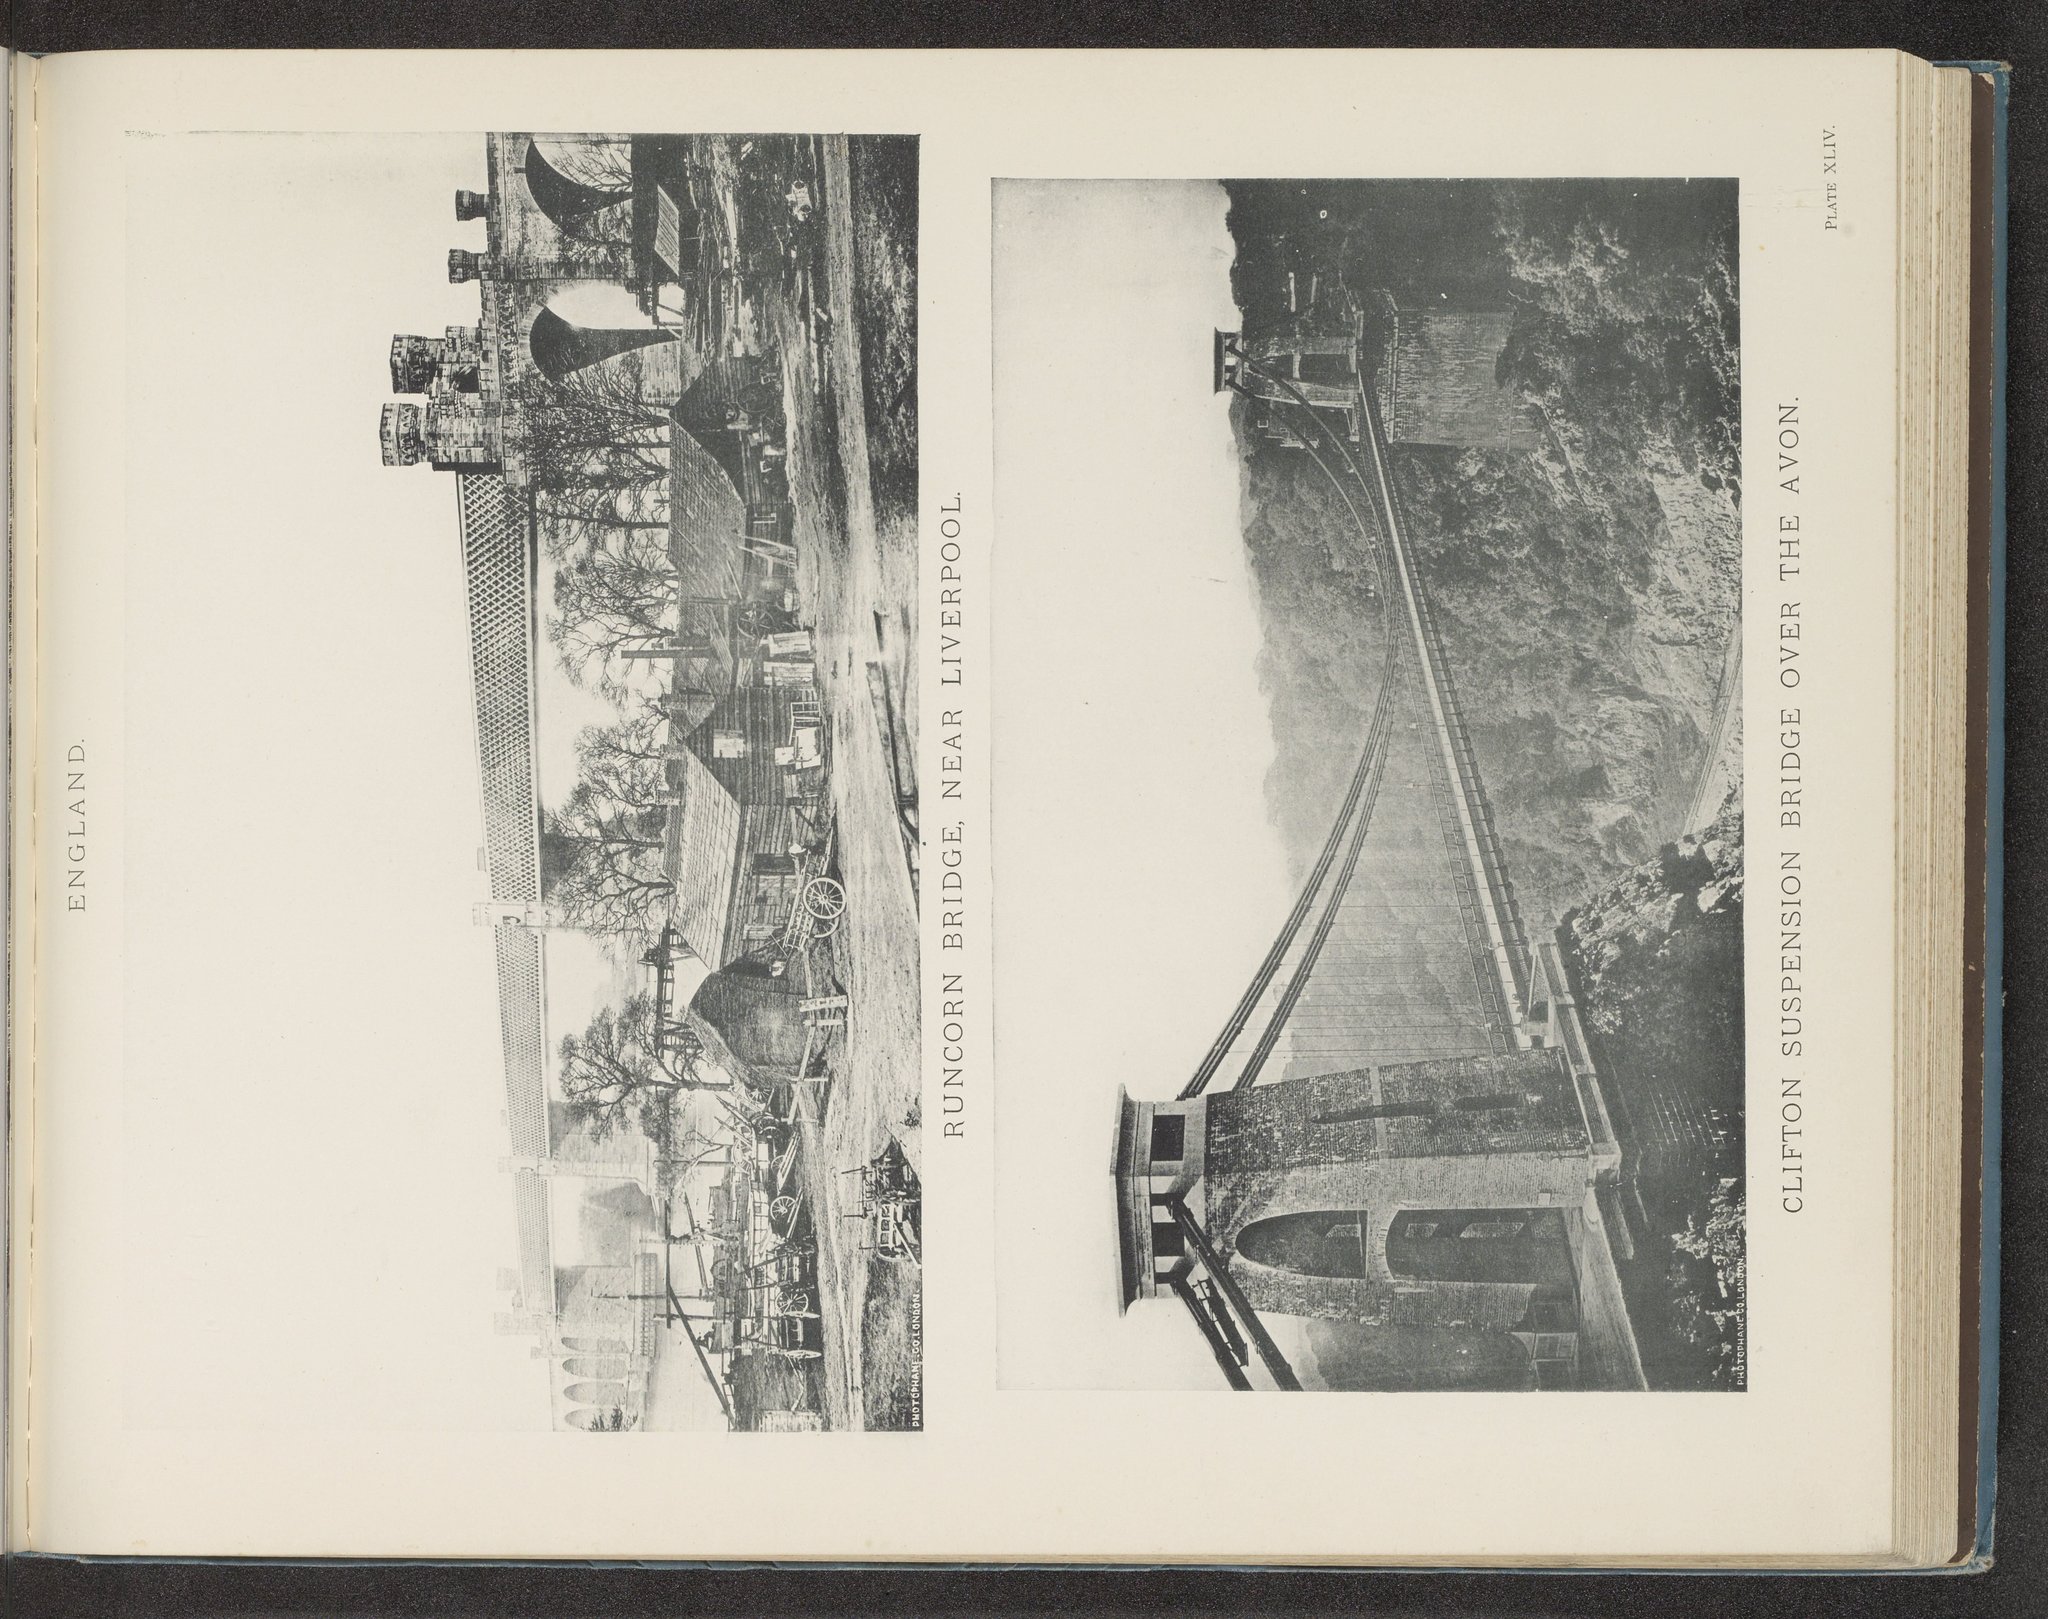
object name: photomechanical print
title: Clifton Suspension Bridge over the Avon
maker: Anonymous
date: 1880-1890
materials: paper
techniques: photograph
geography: london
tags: landscape with bridge, viaduct or aqueduct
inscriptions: inscription: ‘England.’, number: ‘Plate XLIV.’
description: Boven de Runcorn Bridge, onder de Clifton Suspension Bridge.